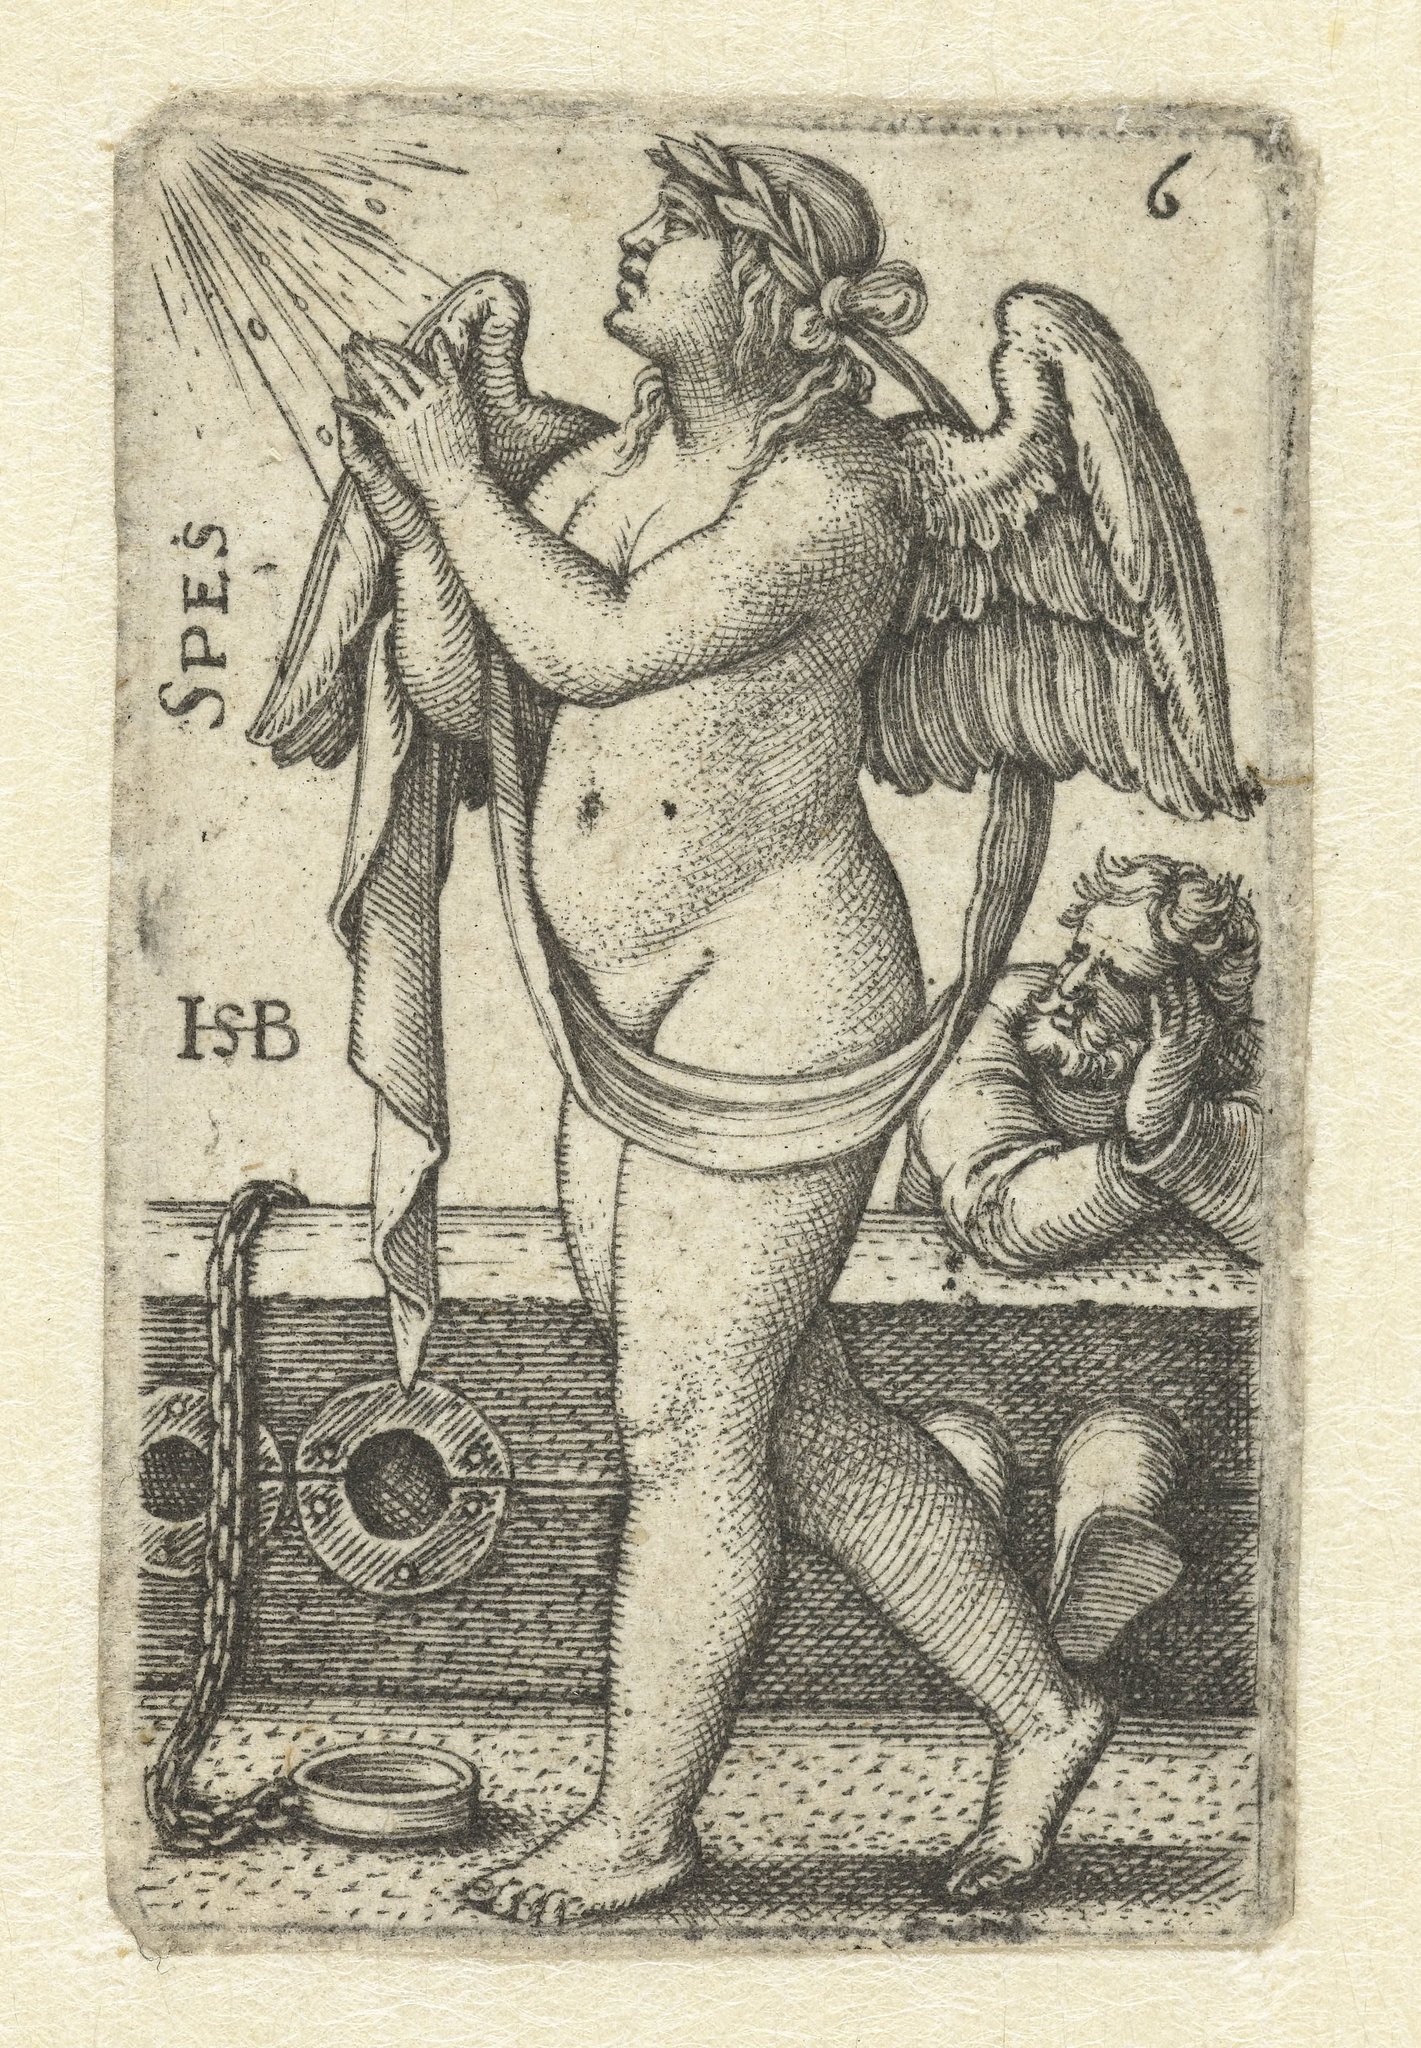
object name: print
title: Hoop (Spes)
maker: hans sebald beham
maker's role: designer, draughtsman, print maker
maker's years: 1500-1550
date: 1539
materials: paper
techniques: engraving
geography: frankfurt am main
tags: hope, 'spes'; 'speranza divina e certa' (ripa) ~ one of the three theological virtues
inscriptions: collector's mark: Lugt 2228a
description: Gevleugelde vrouw als personificatie van Hoop (Spes) met haar handen gevouwen en een gevangene aan een ketting